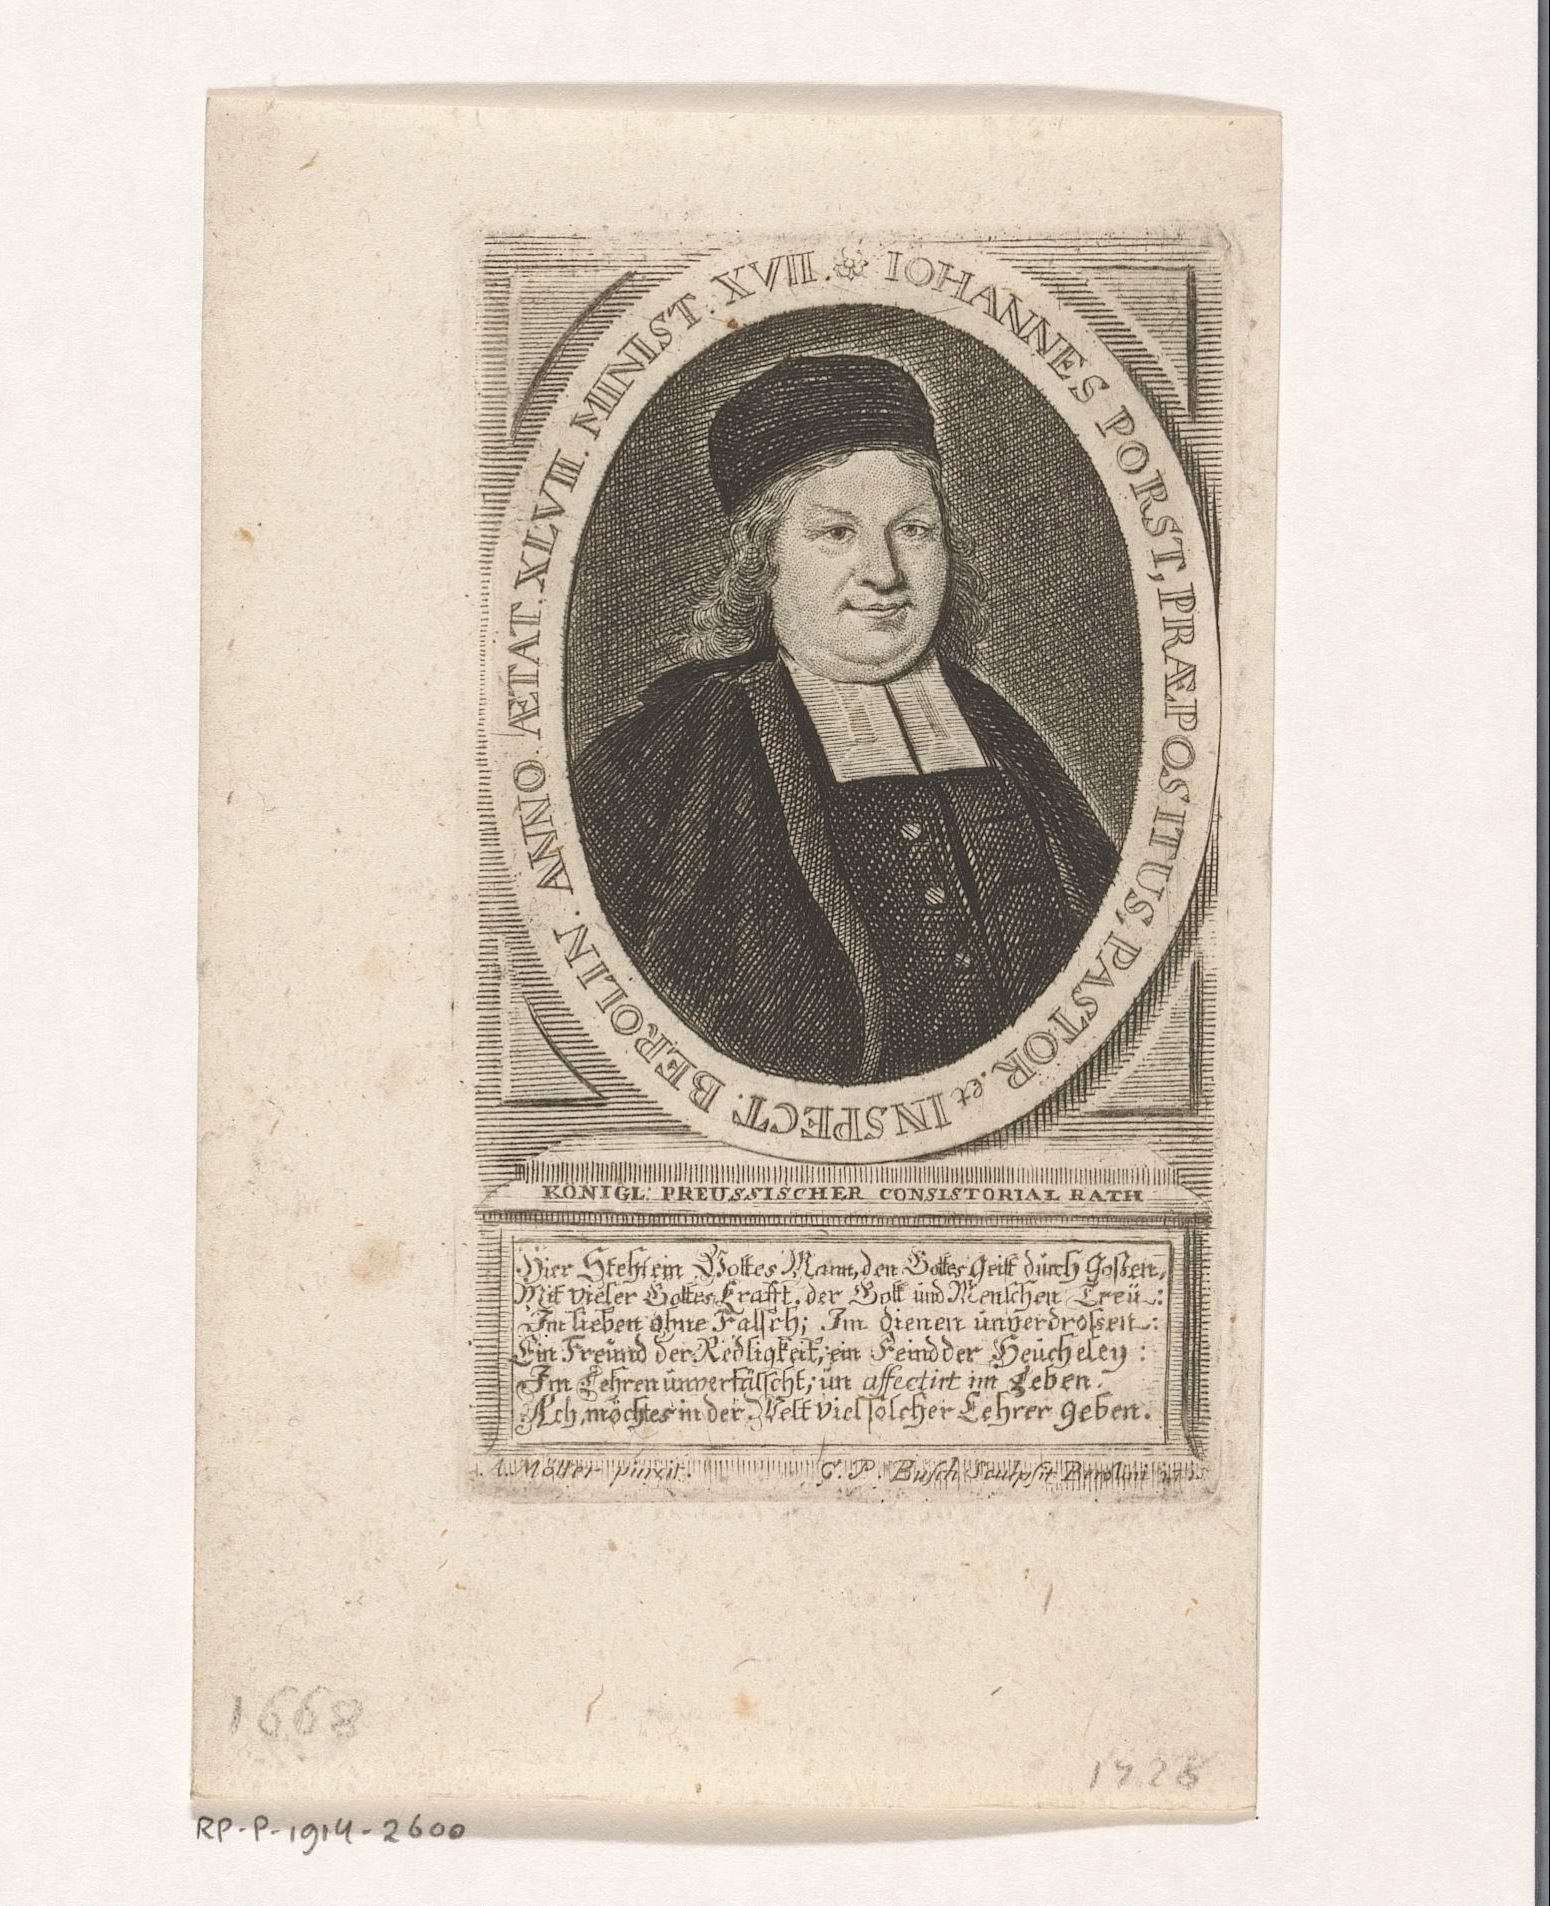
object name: print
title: Portret van Johann Porst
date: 1715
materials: paper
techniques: engraving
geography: berlin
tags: berlin, historical persons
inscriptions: collector's mark: Lugt 2228